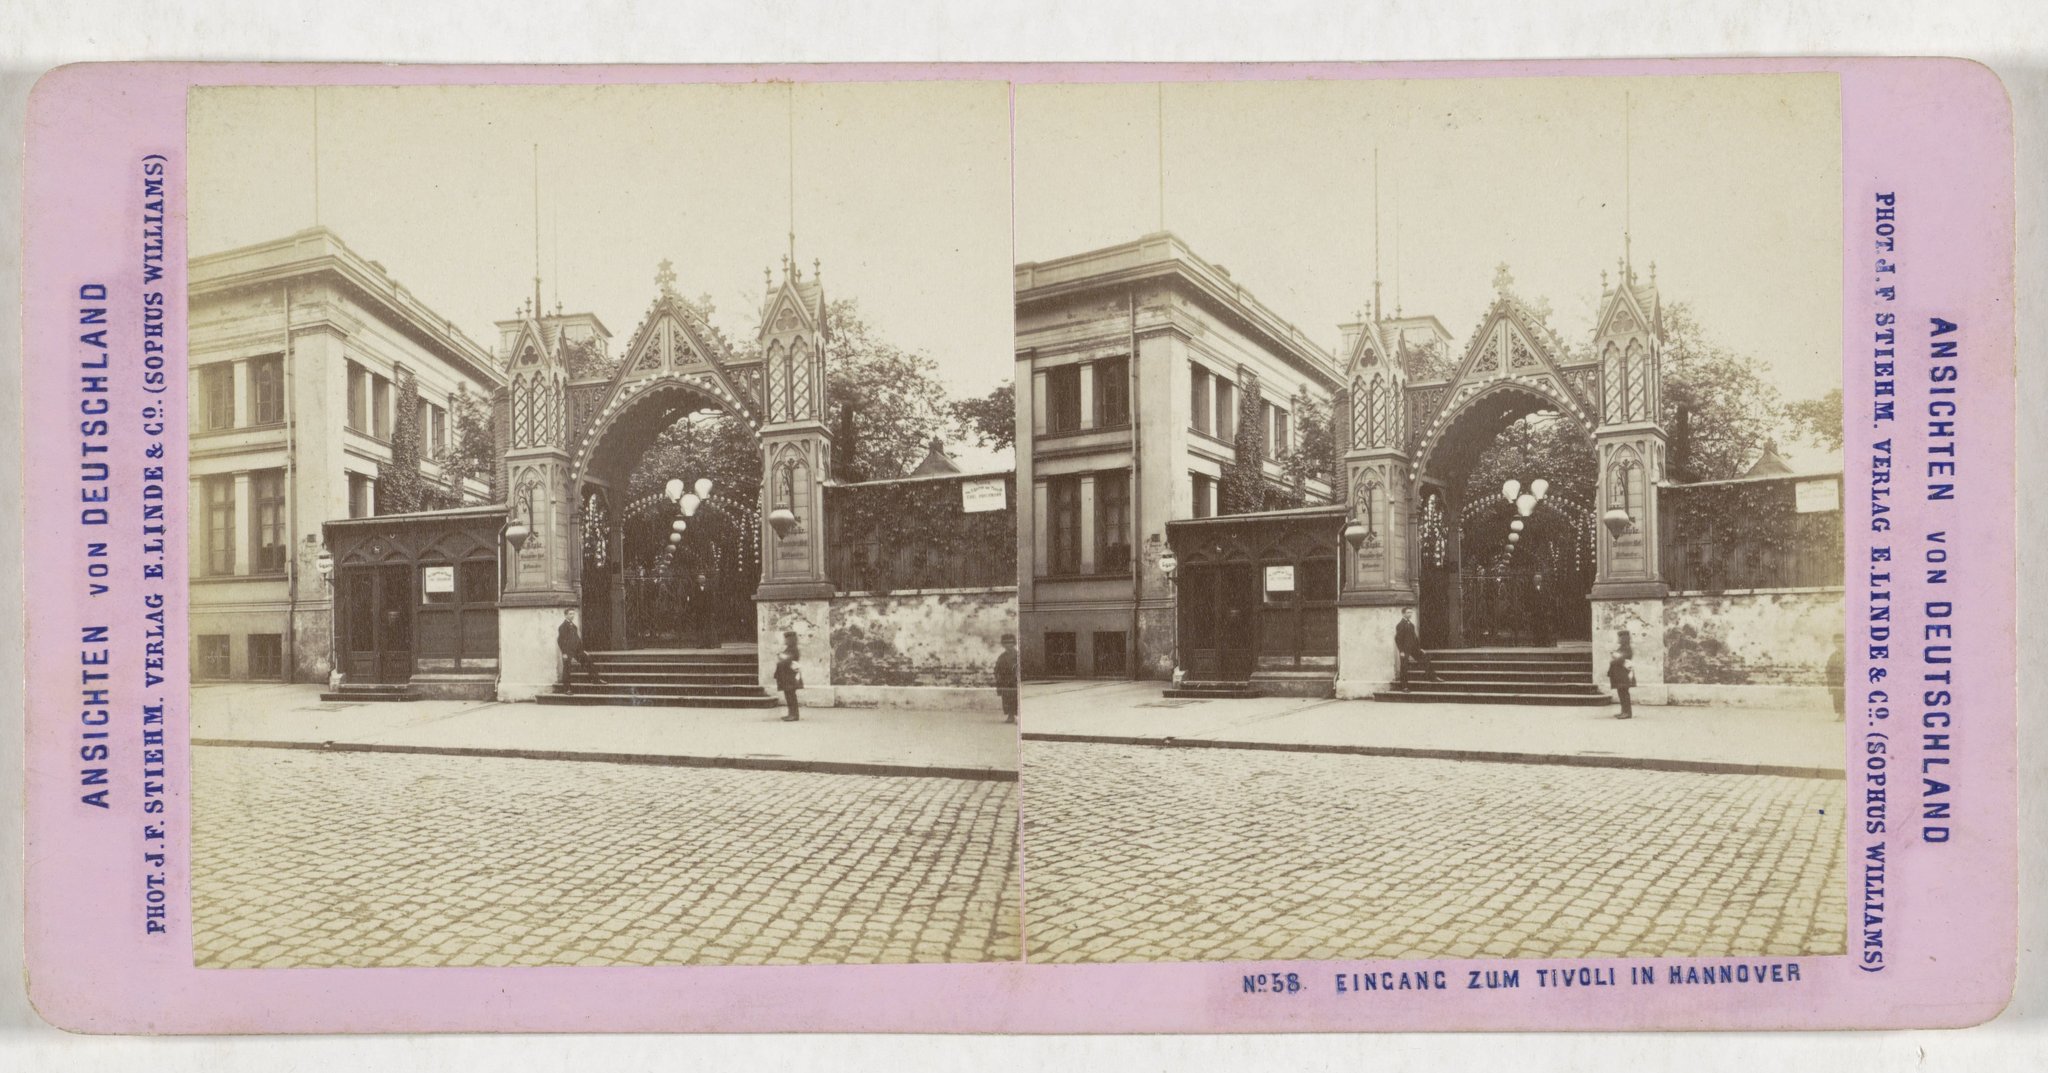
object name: stereograph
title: Ingang van het Tivolipark in Hannover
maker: johann friedrich stiehm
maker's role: fotograaf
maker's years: 1826-1902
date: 1869-1872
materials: cardboard, paper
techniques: albumen print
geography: berlin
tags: park, open-air recreation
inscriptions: number: ‘No 58.’